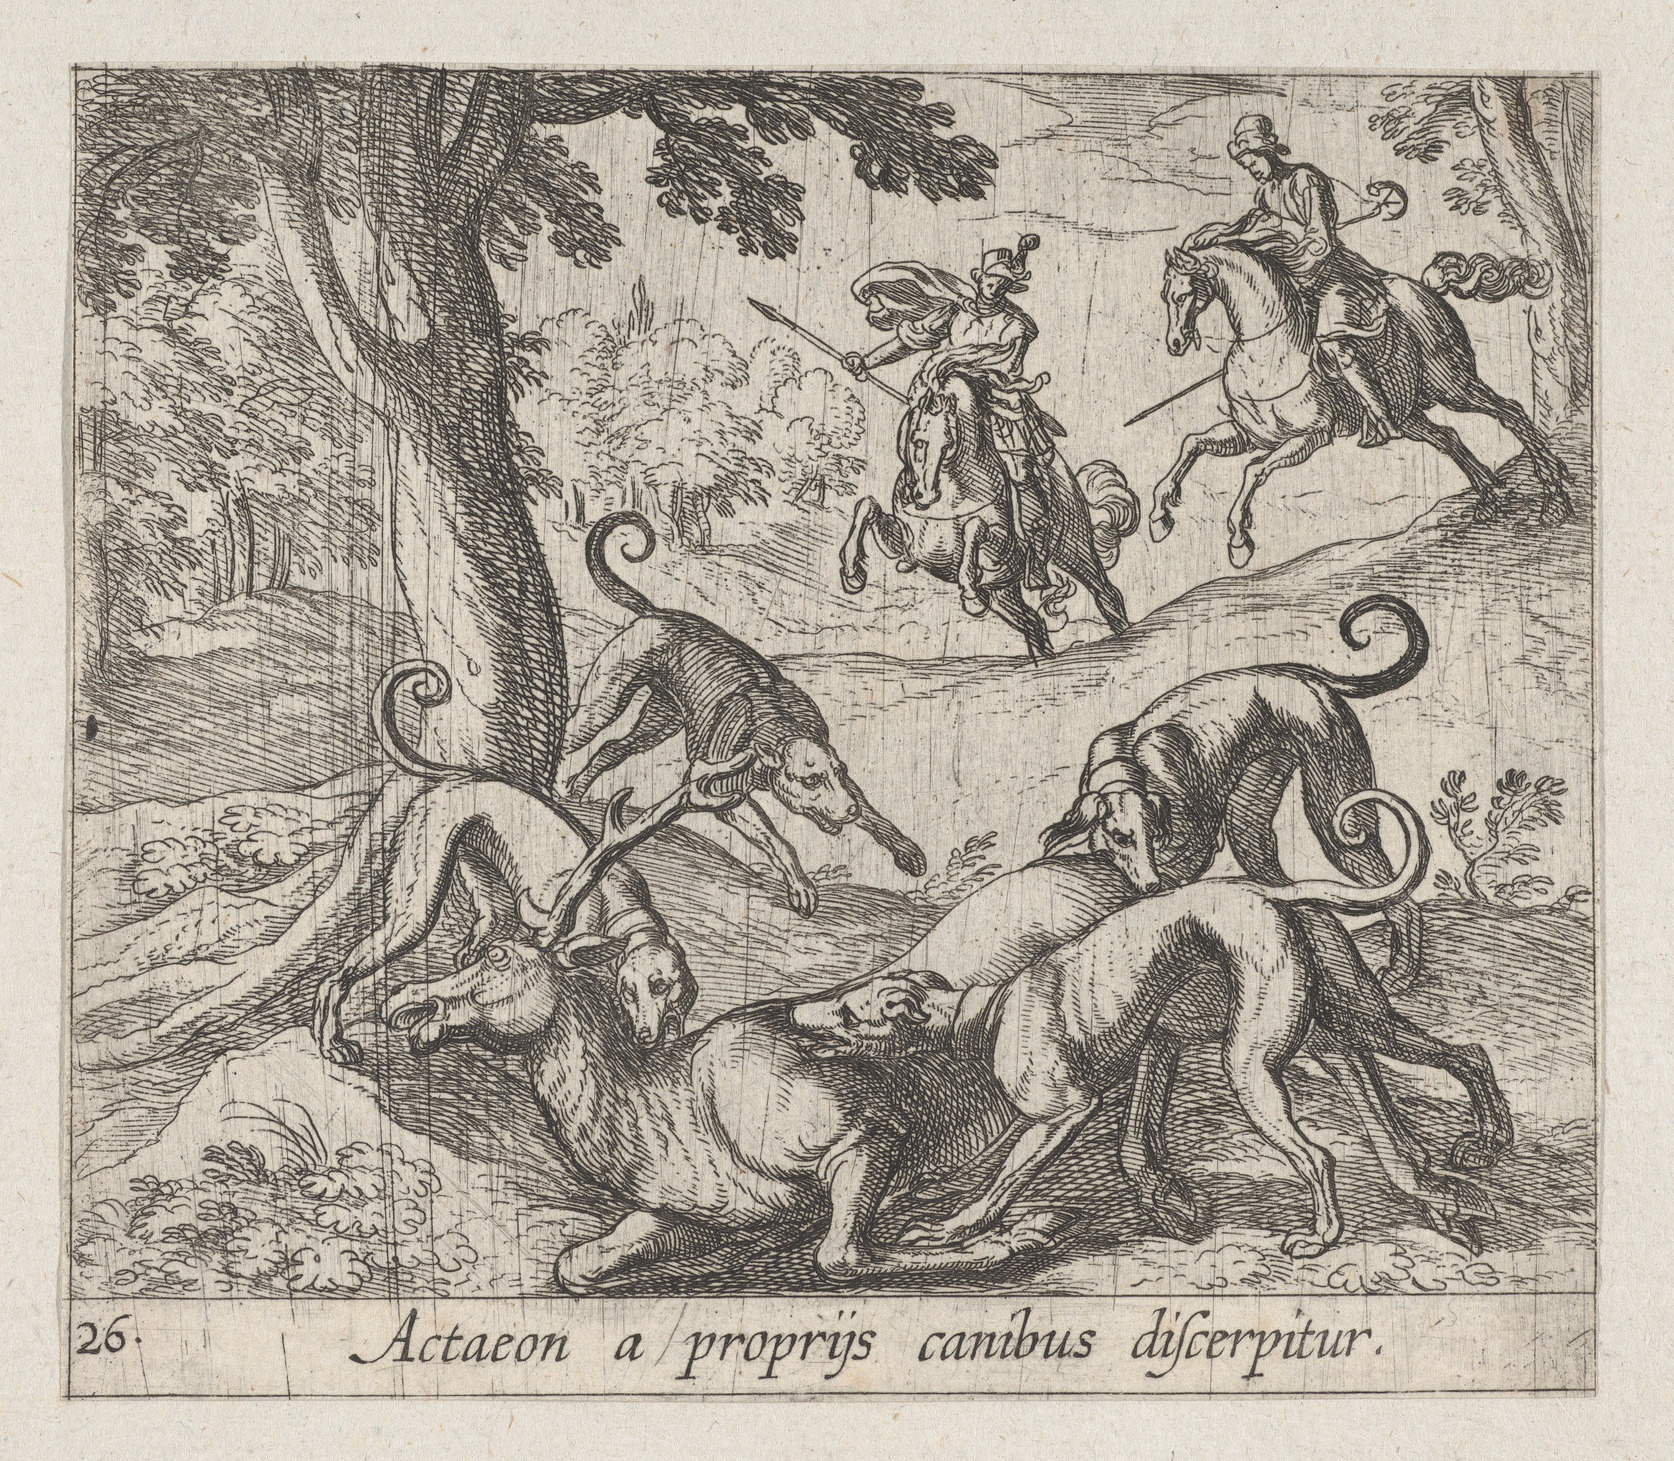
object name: print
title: Plate 26: Actaeon Killed by His Dogs (Actaeon a proprÿs canibus discerpitur), from Ovid's 'Metamorphoses'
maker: antonio tempesta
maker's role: artist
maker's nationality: italian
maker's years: 1555-1630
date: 1606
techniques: etching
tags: weapons,men,actaeon,dogs,horses